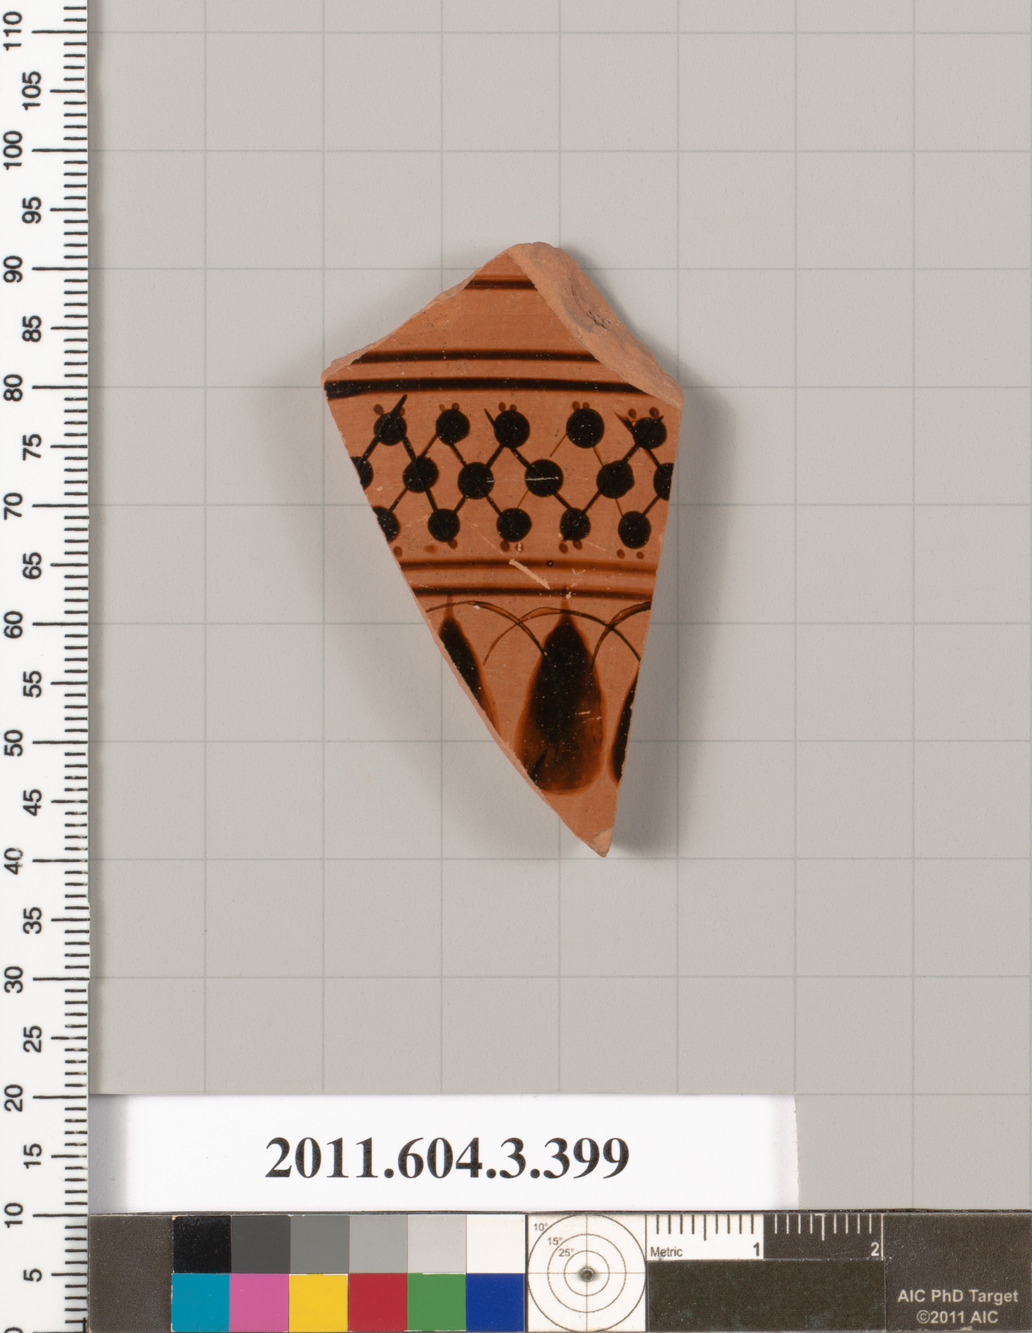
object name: neck amphora fragment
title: Terracotta fragment of a neck-amphora (jar)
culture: greek, attic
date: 500-468 BCE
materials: terracotta